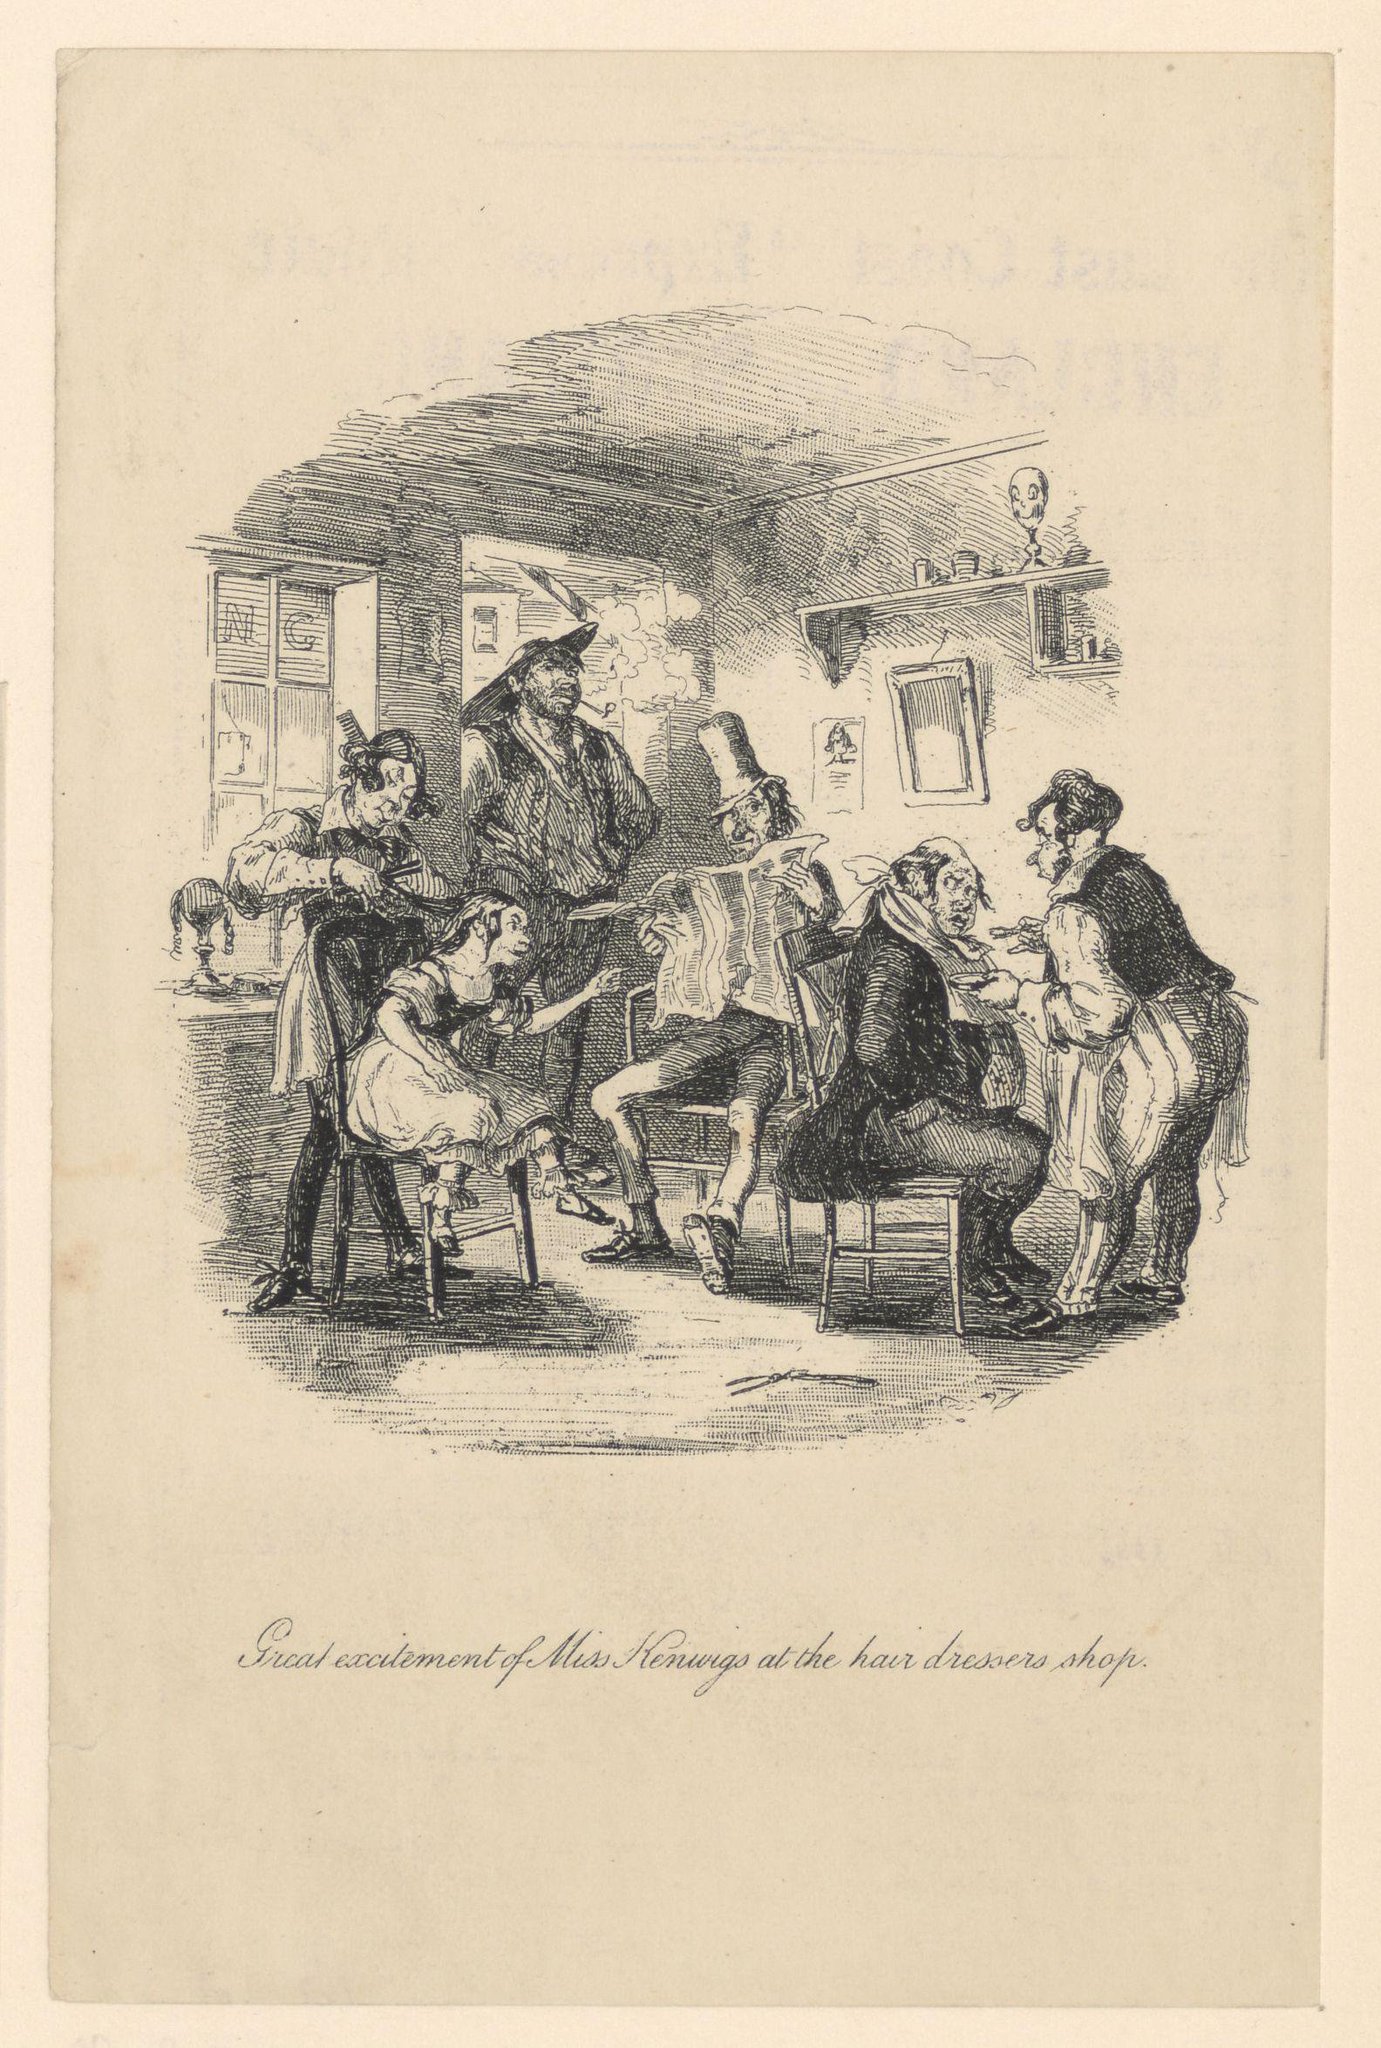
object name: book illustration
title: Great excitement of Miss Kenwigs at the Hairdresser's shop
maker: hablot knight browne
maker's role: print maker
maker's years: 1815-1882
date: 1839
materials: paper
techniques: etching, roulette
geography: london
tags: looking over the shoulder, mocking, insulting; teasing, hairdresser, index finger forwards, pointing, indicating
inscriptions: collector's mark: Lugt 2228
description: Prent uit: Prent uit: Dickens, Charles. Nicholas Nickleby. Londen: Chapman and Hall, 1839. Het boek werd eerst in delen uitgegeven vanaf maart 1838.